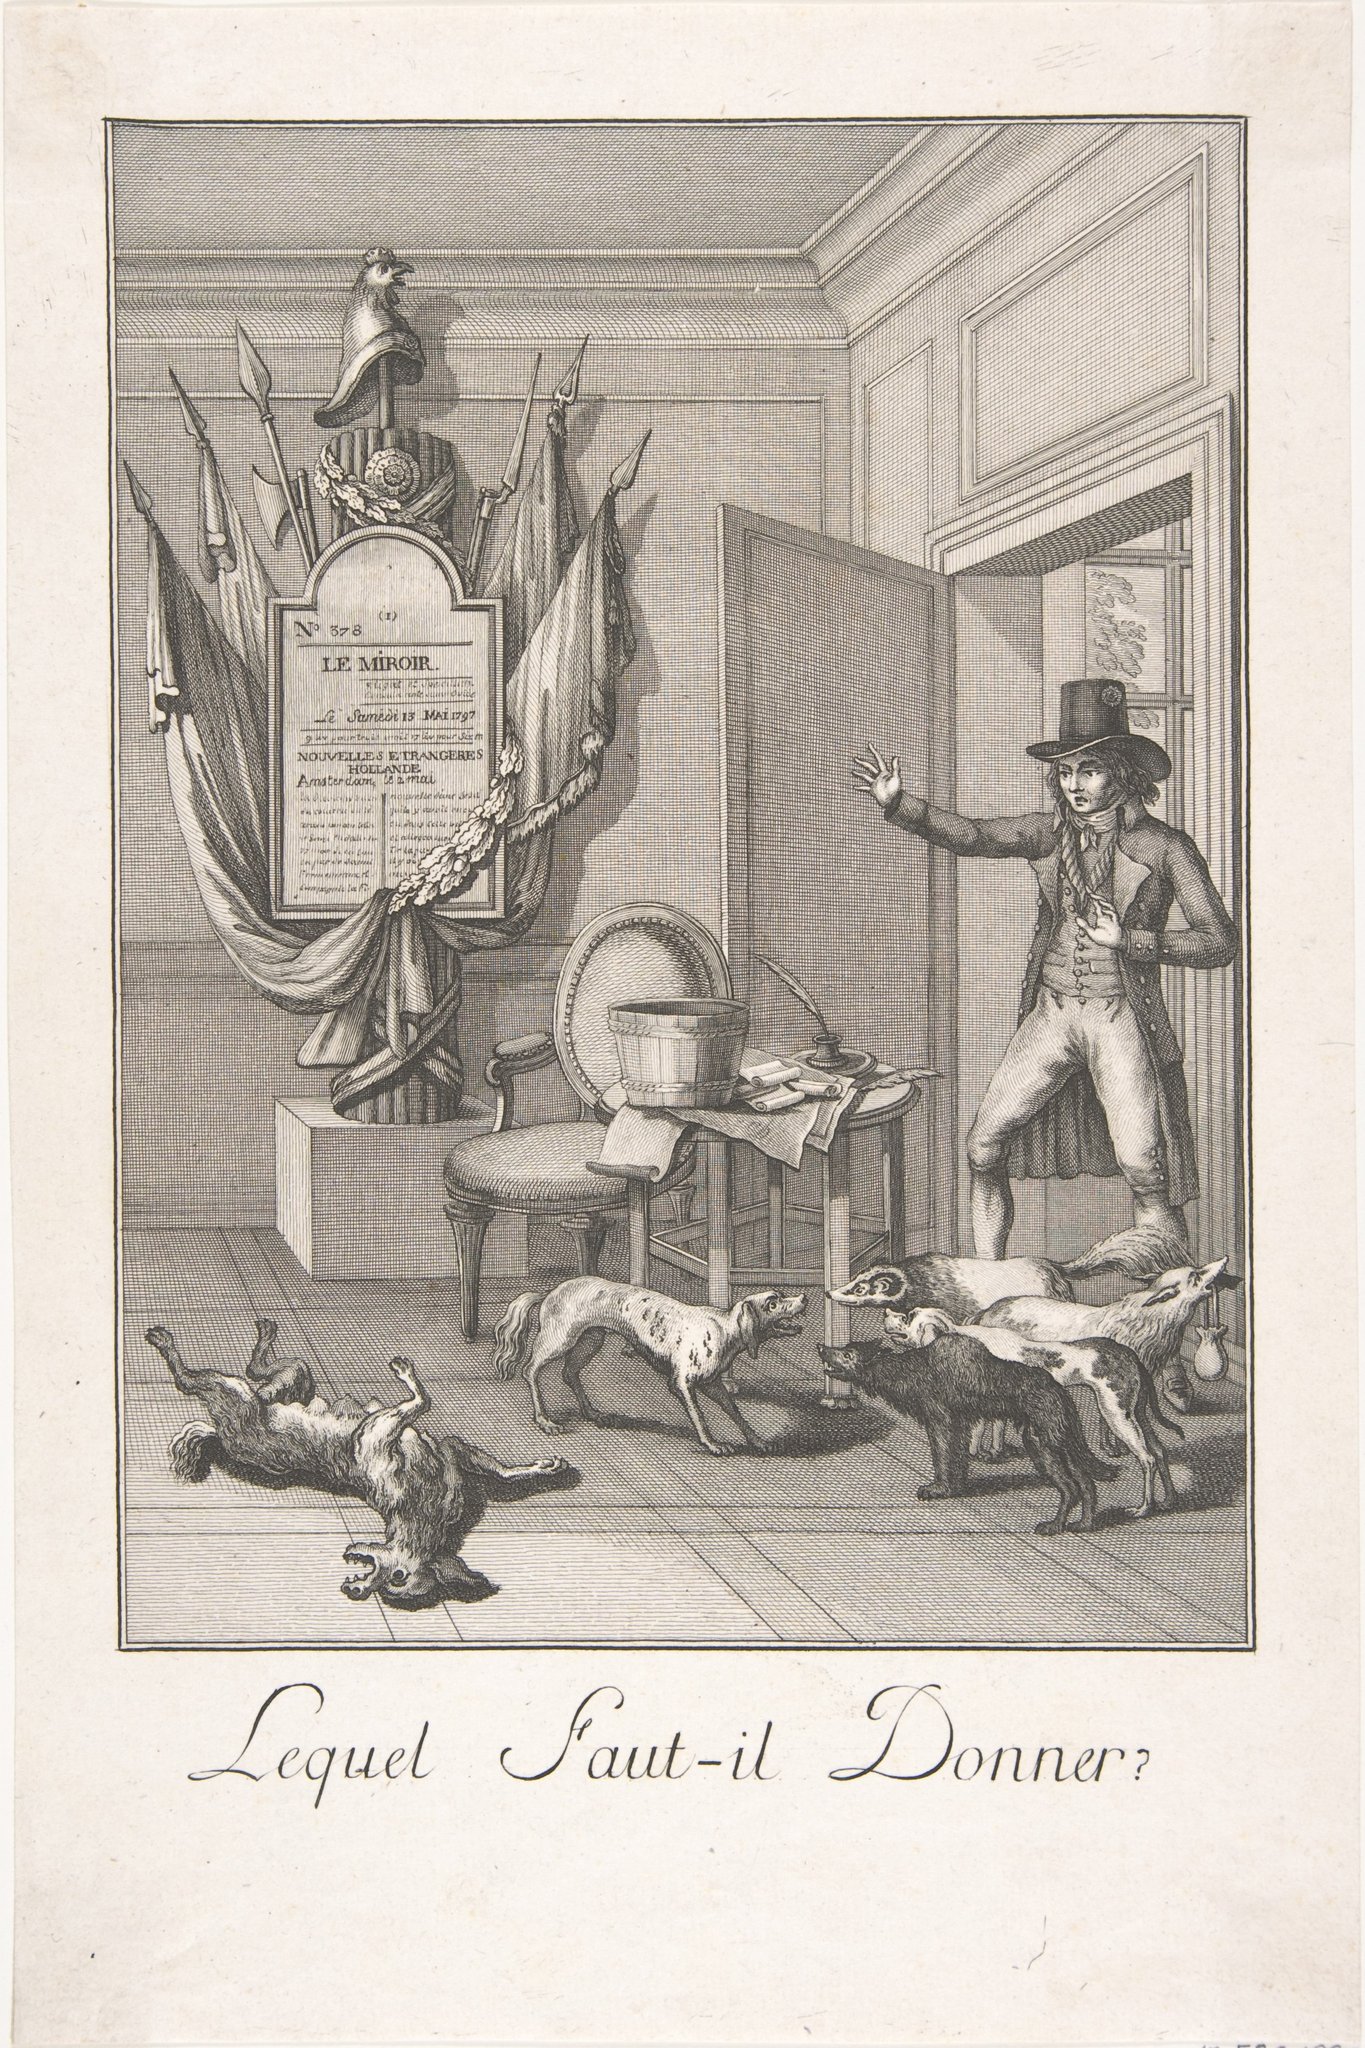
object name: print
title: Lequel Faut-il Donner?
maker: anonymous, french, 18th century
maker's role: artist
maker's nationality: french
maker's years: 1700-1800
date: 1797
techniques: engraving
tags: satire,men,dogs